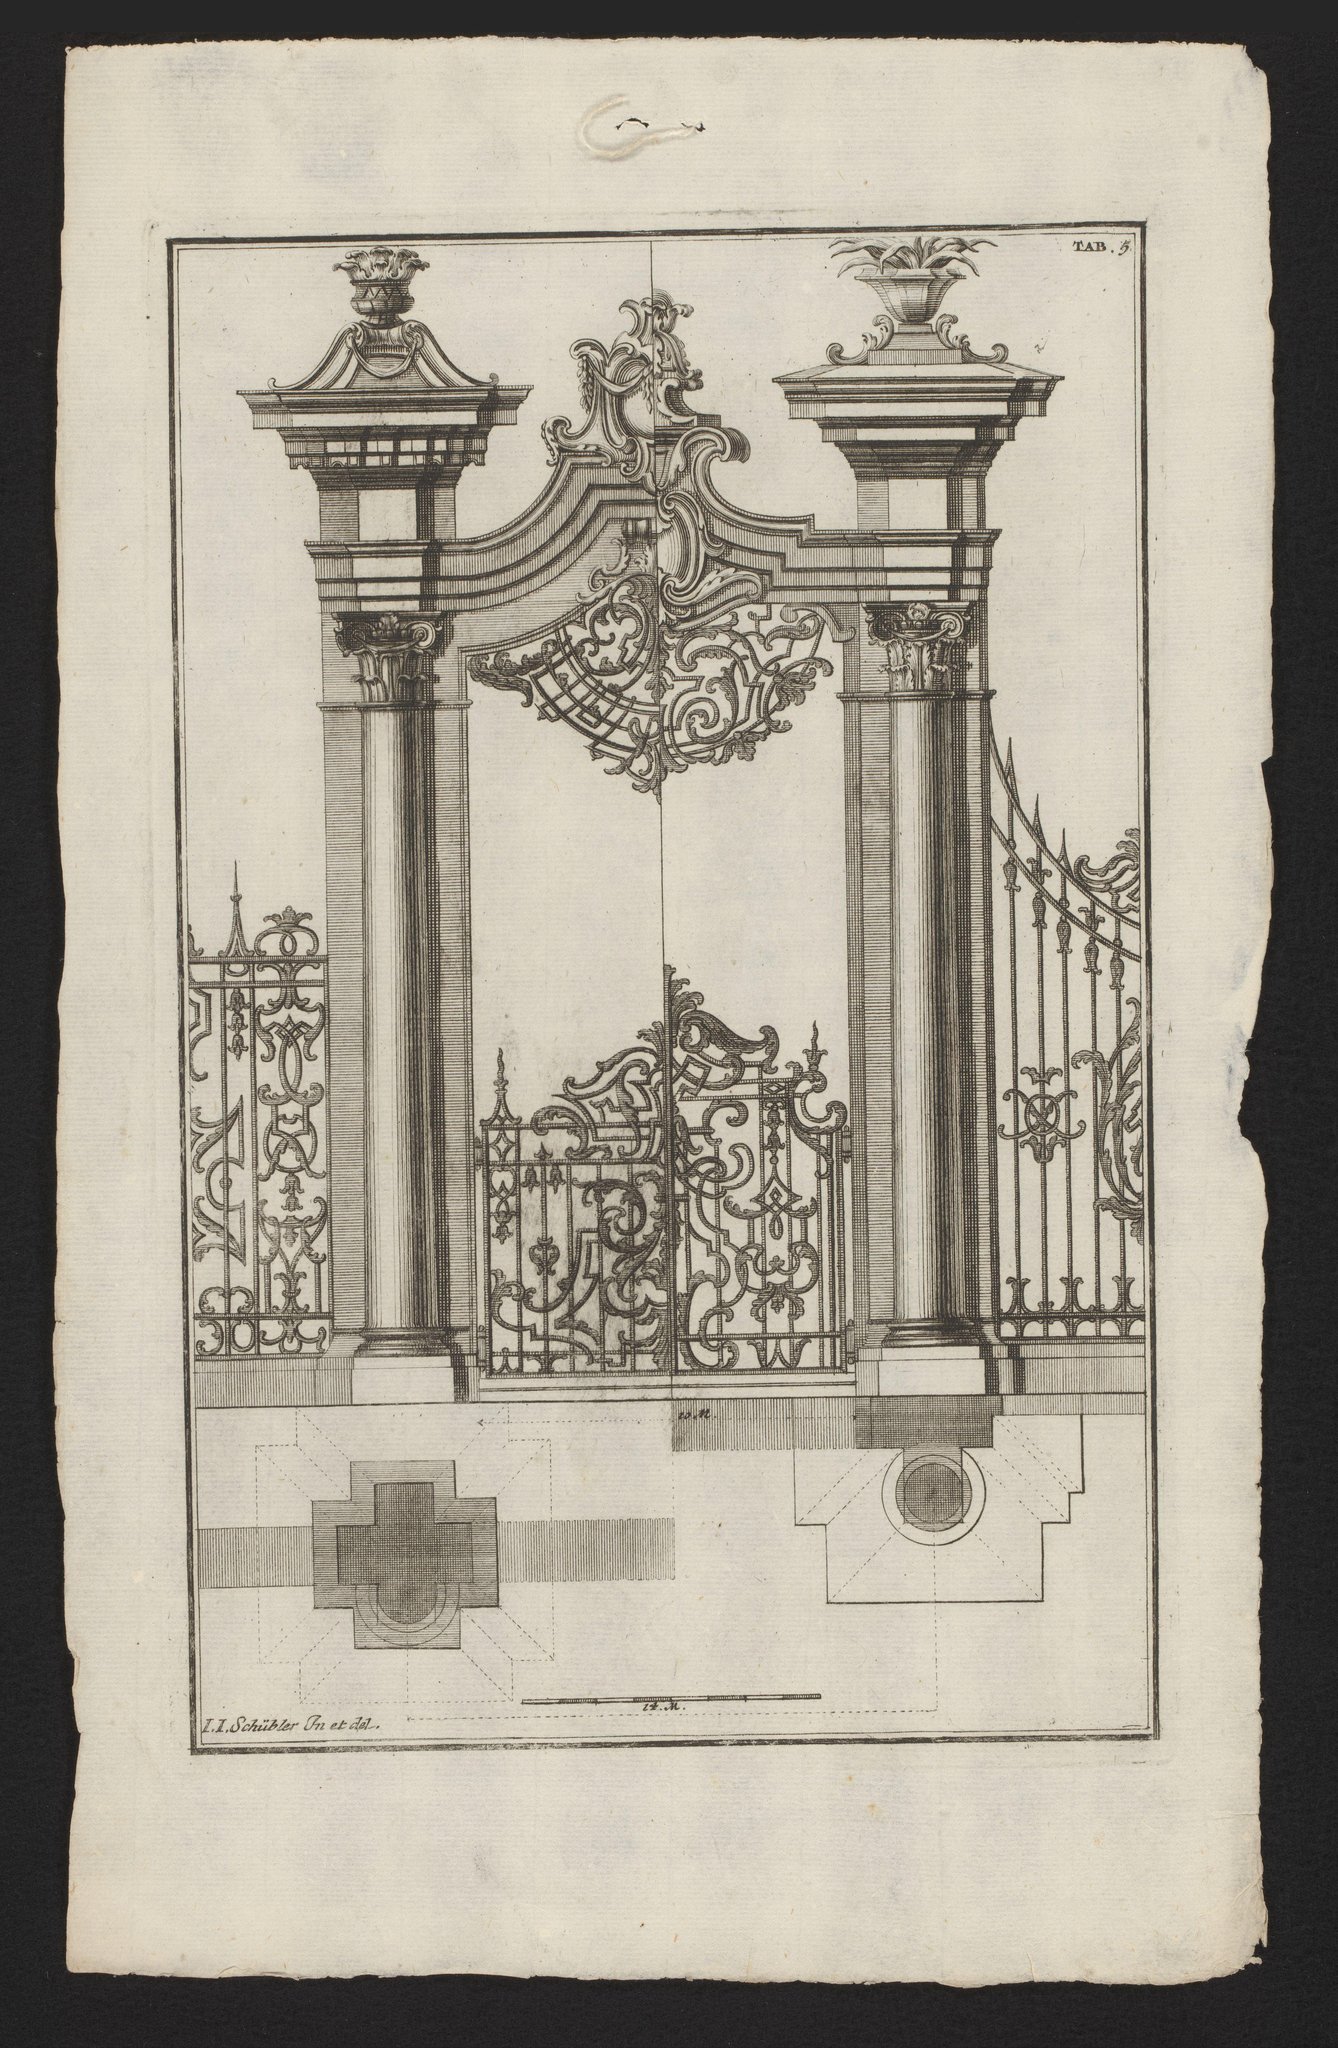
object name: ornament print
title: Tuinportaal met laag hekwerk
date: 1699-1726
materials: paper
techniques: engraving, etching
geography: nuremberg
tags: column, pillar ~ architecture, vase ~ ornament, fence, wall, paling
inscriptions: collector's mark: Lugt 2228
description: Prent uit: Schübler, Johann Jakob. Weitere Eröffnung zur Gründlichen Säulen Ordnung von neu inventirten Garten Portalen (...). [Neurenberg]: Weigel, Johann Christoph, [voor 1726].